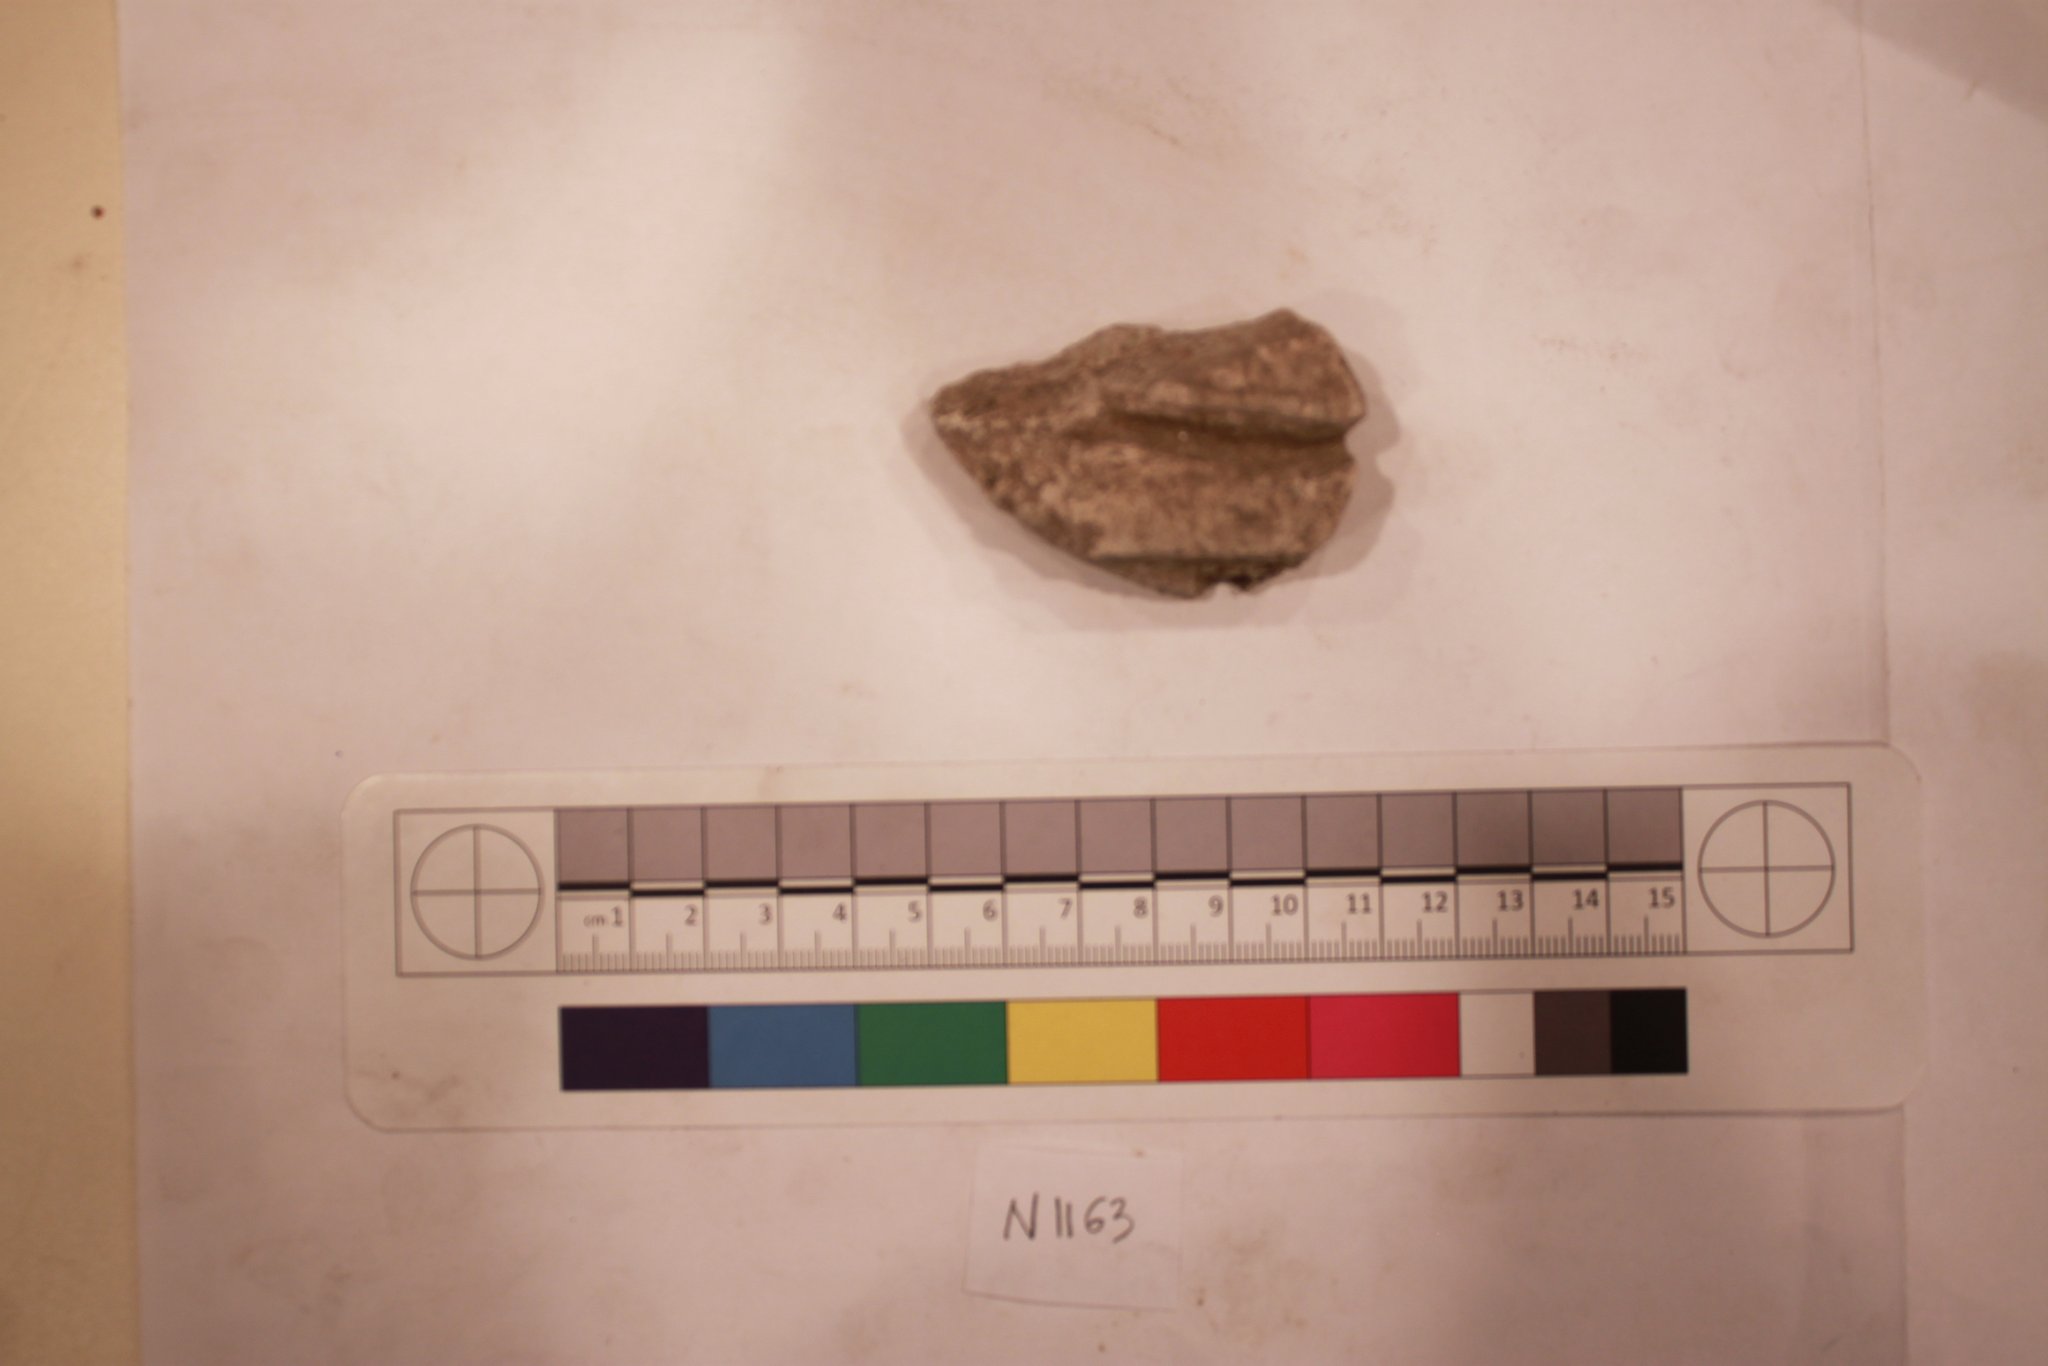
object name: fragment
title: Stucco Fragment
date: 701-1200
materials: plaster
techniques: carving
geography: iran